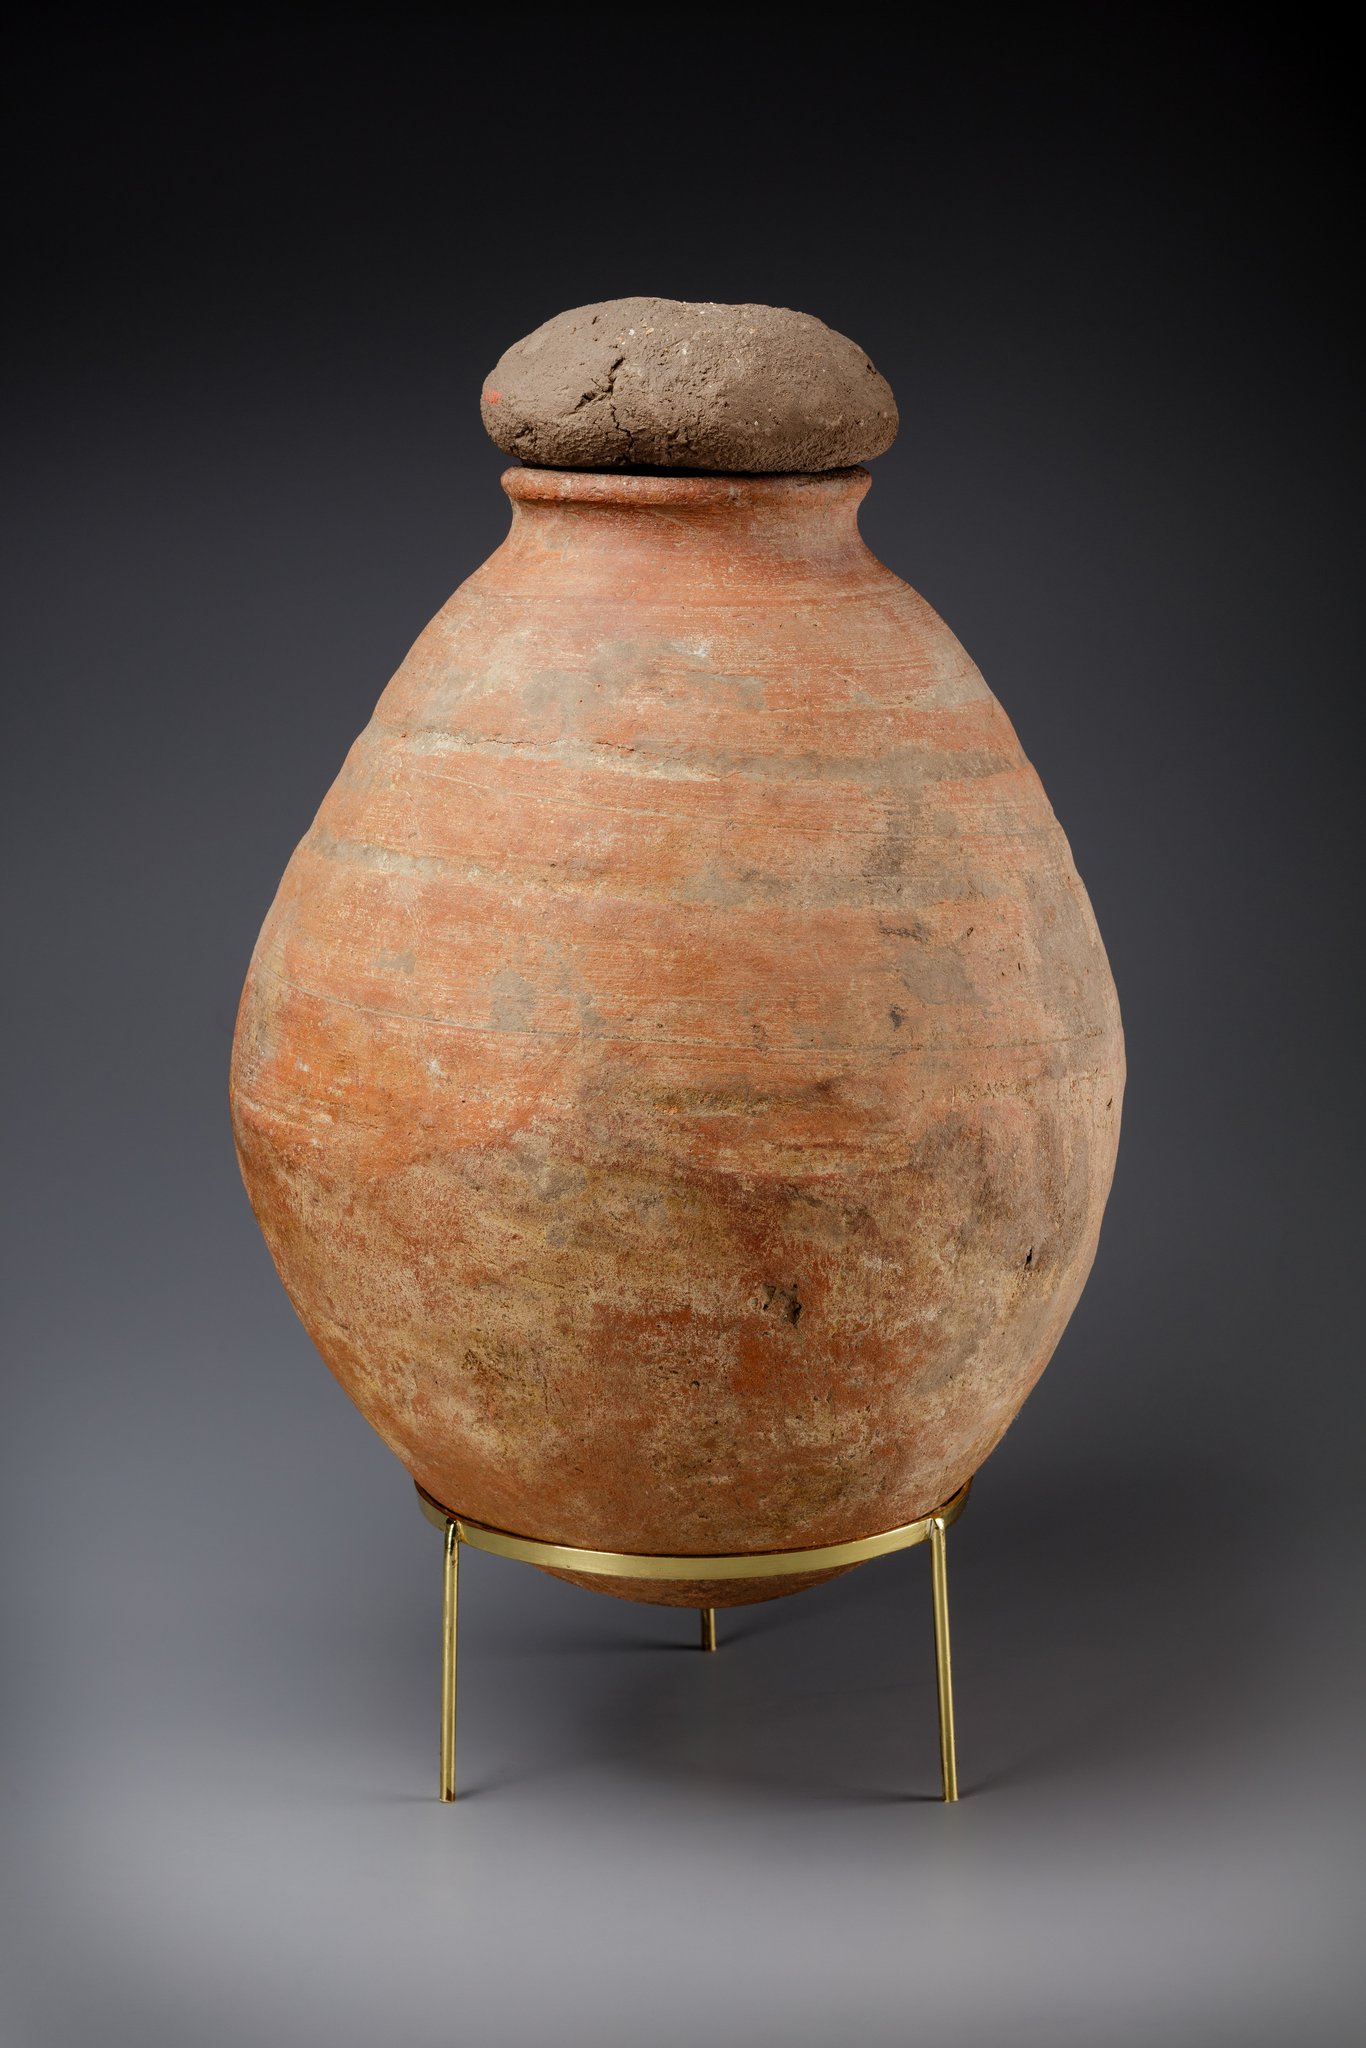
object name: jar, stopper, beer, wah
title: Beer Jar, mud stopper replaced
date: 1981-1975 BCE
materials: mud, pottery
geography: egypt